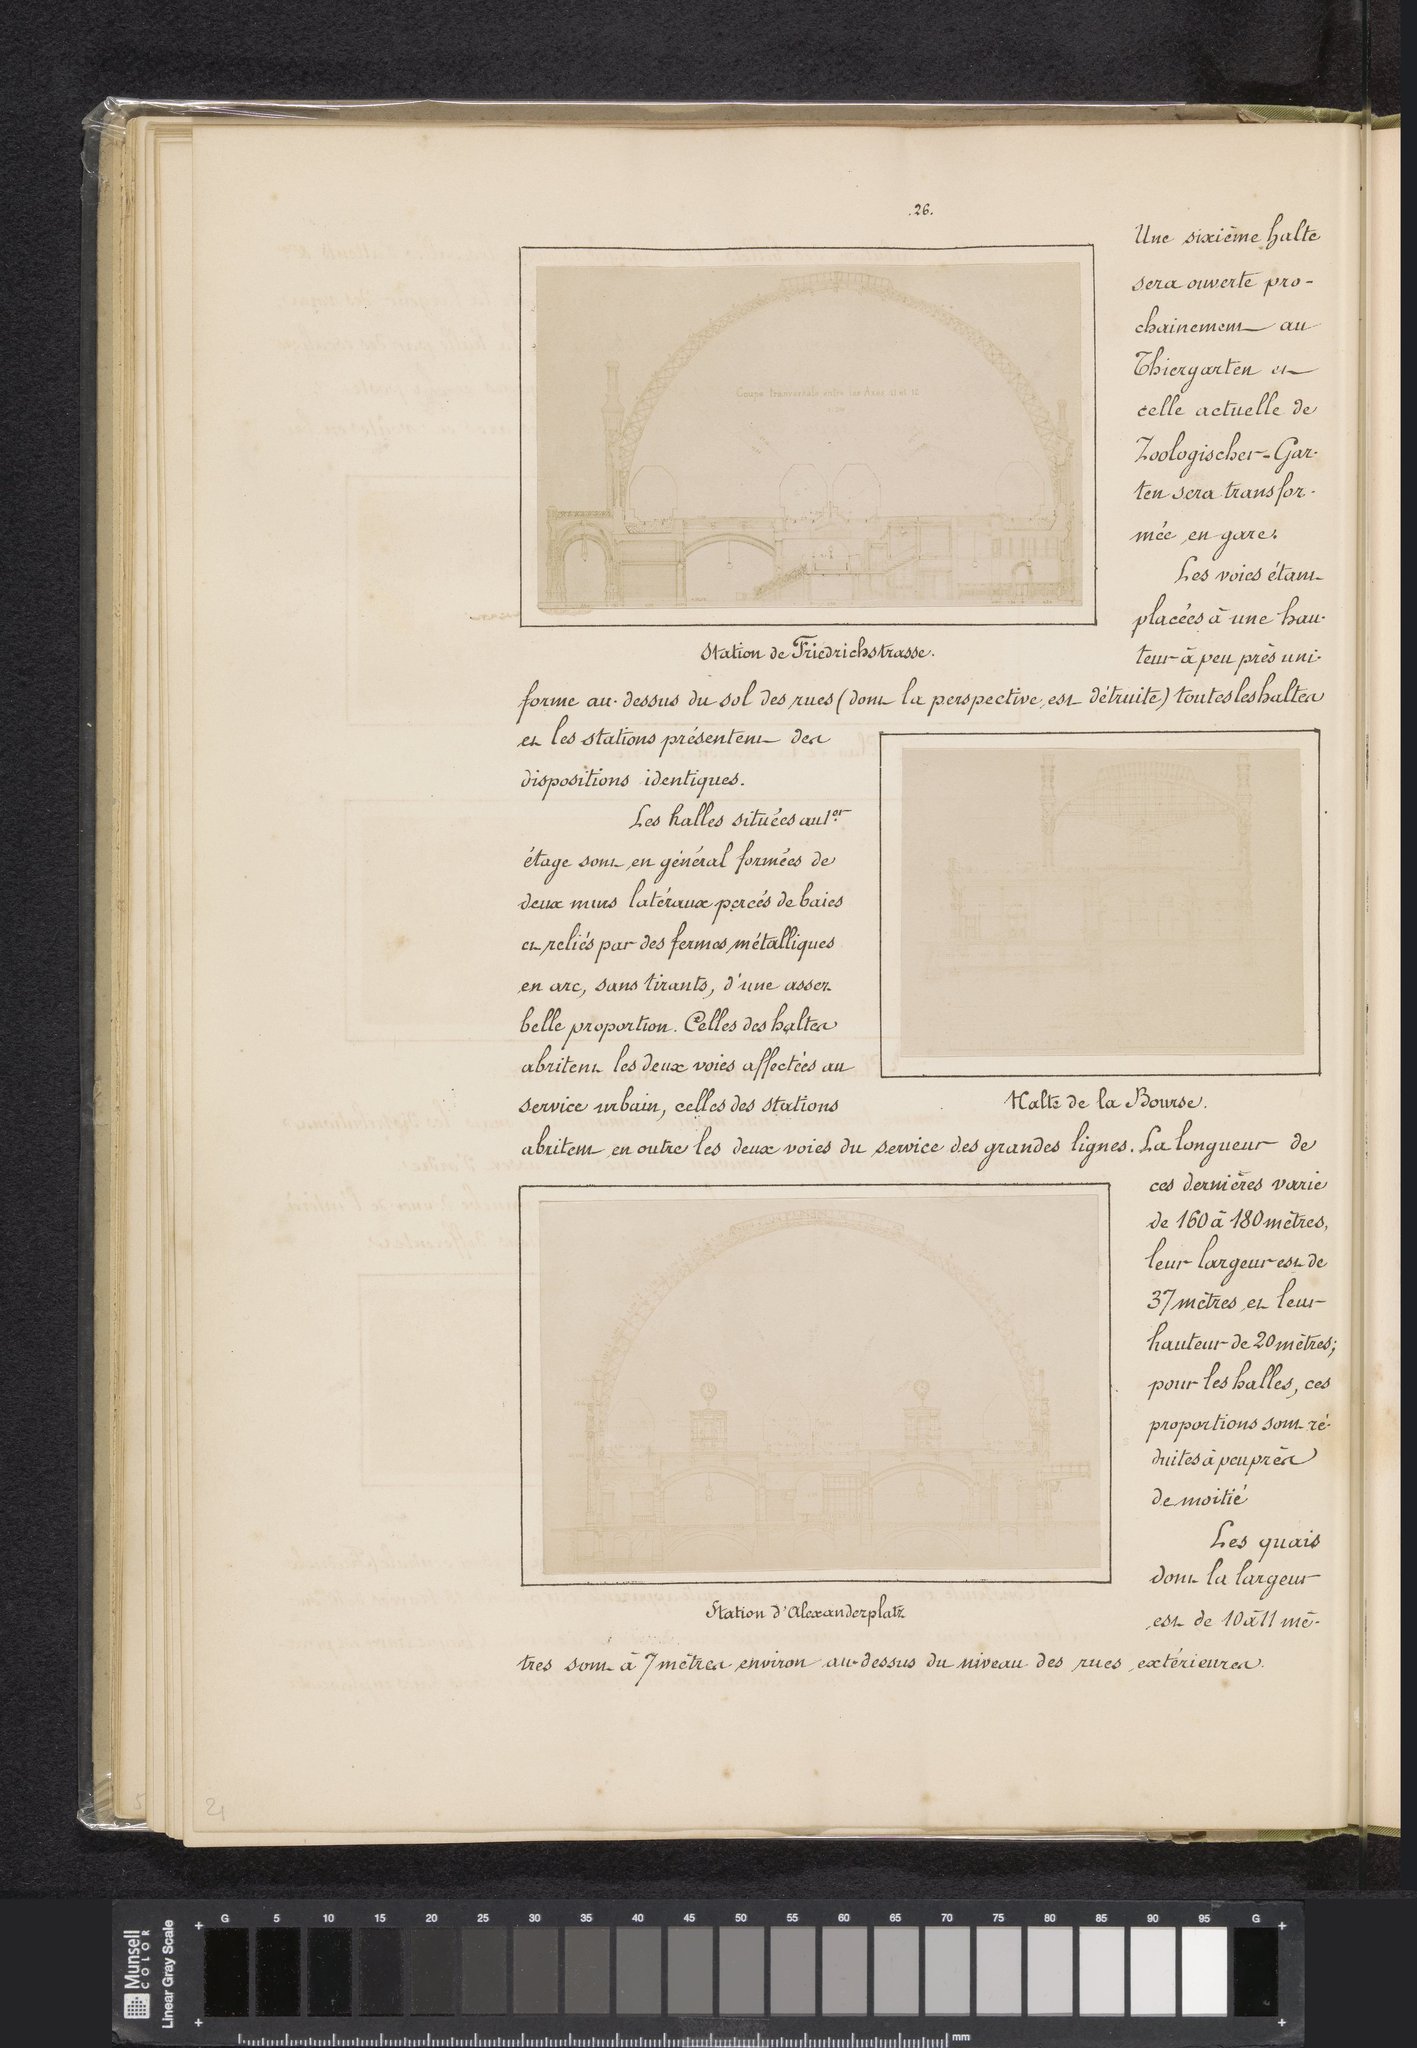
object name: photograph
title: Station d'Alexanderplatz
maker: Anonymous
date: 1874-1884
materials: photographic support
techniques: albumen print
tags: railway, train, interior ~ representation of a building, façade (of house or building), station; shelter (railway, tramway)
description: Boven de stationshal van het station aan de Friedrichstrasse, midden het stationsgebouw bij halte Börse, onder de stationshal van het station aan Alexanderplatz.